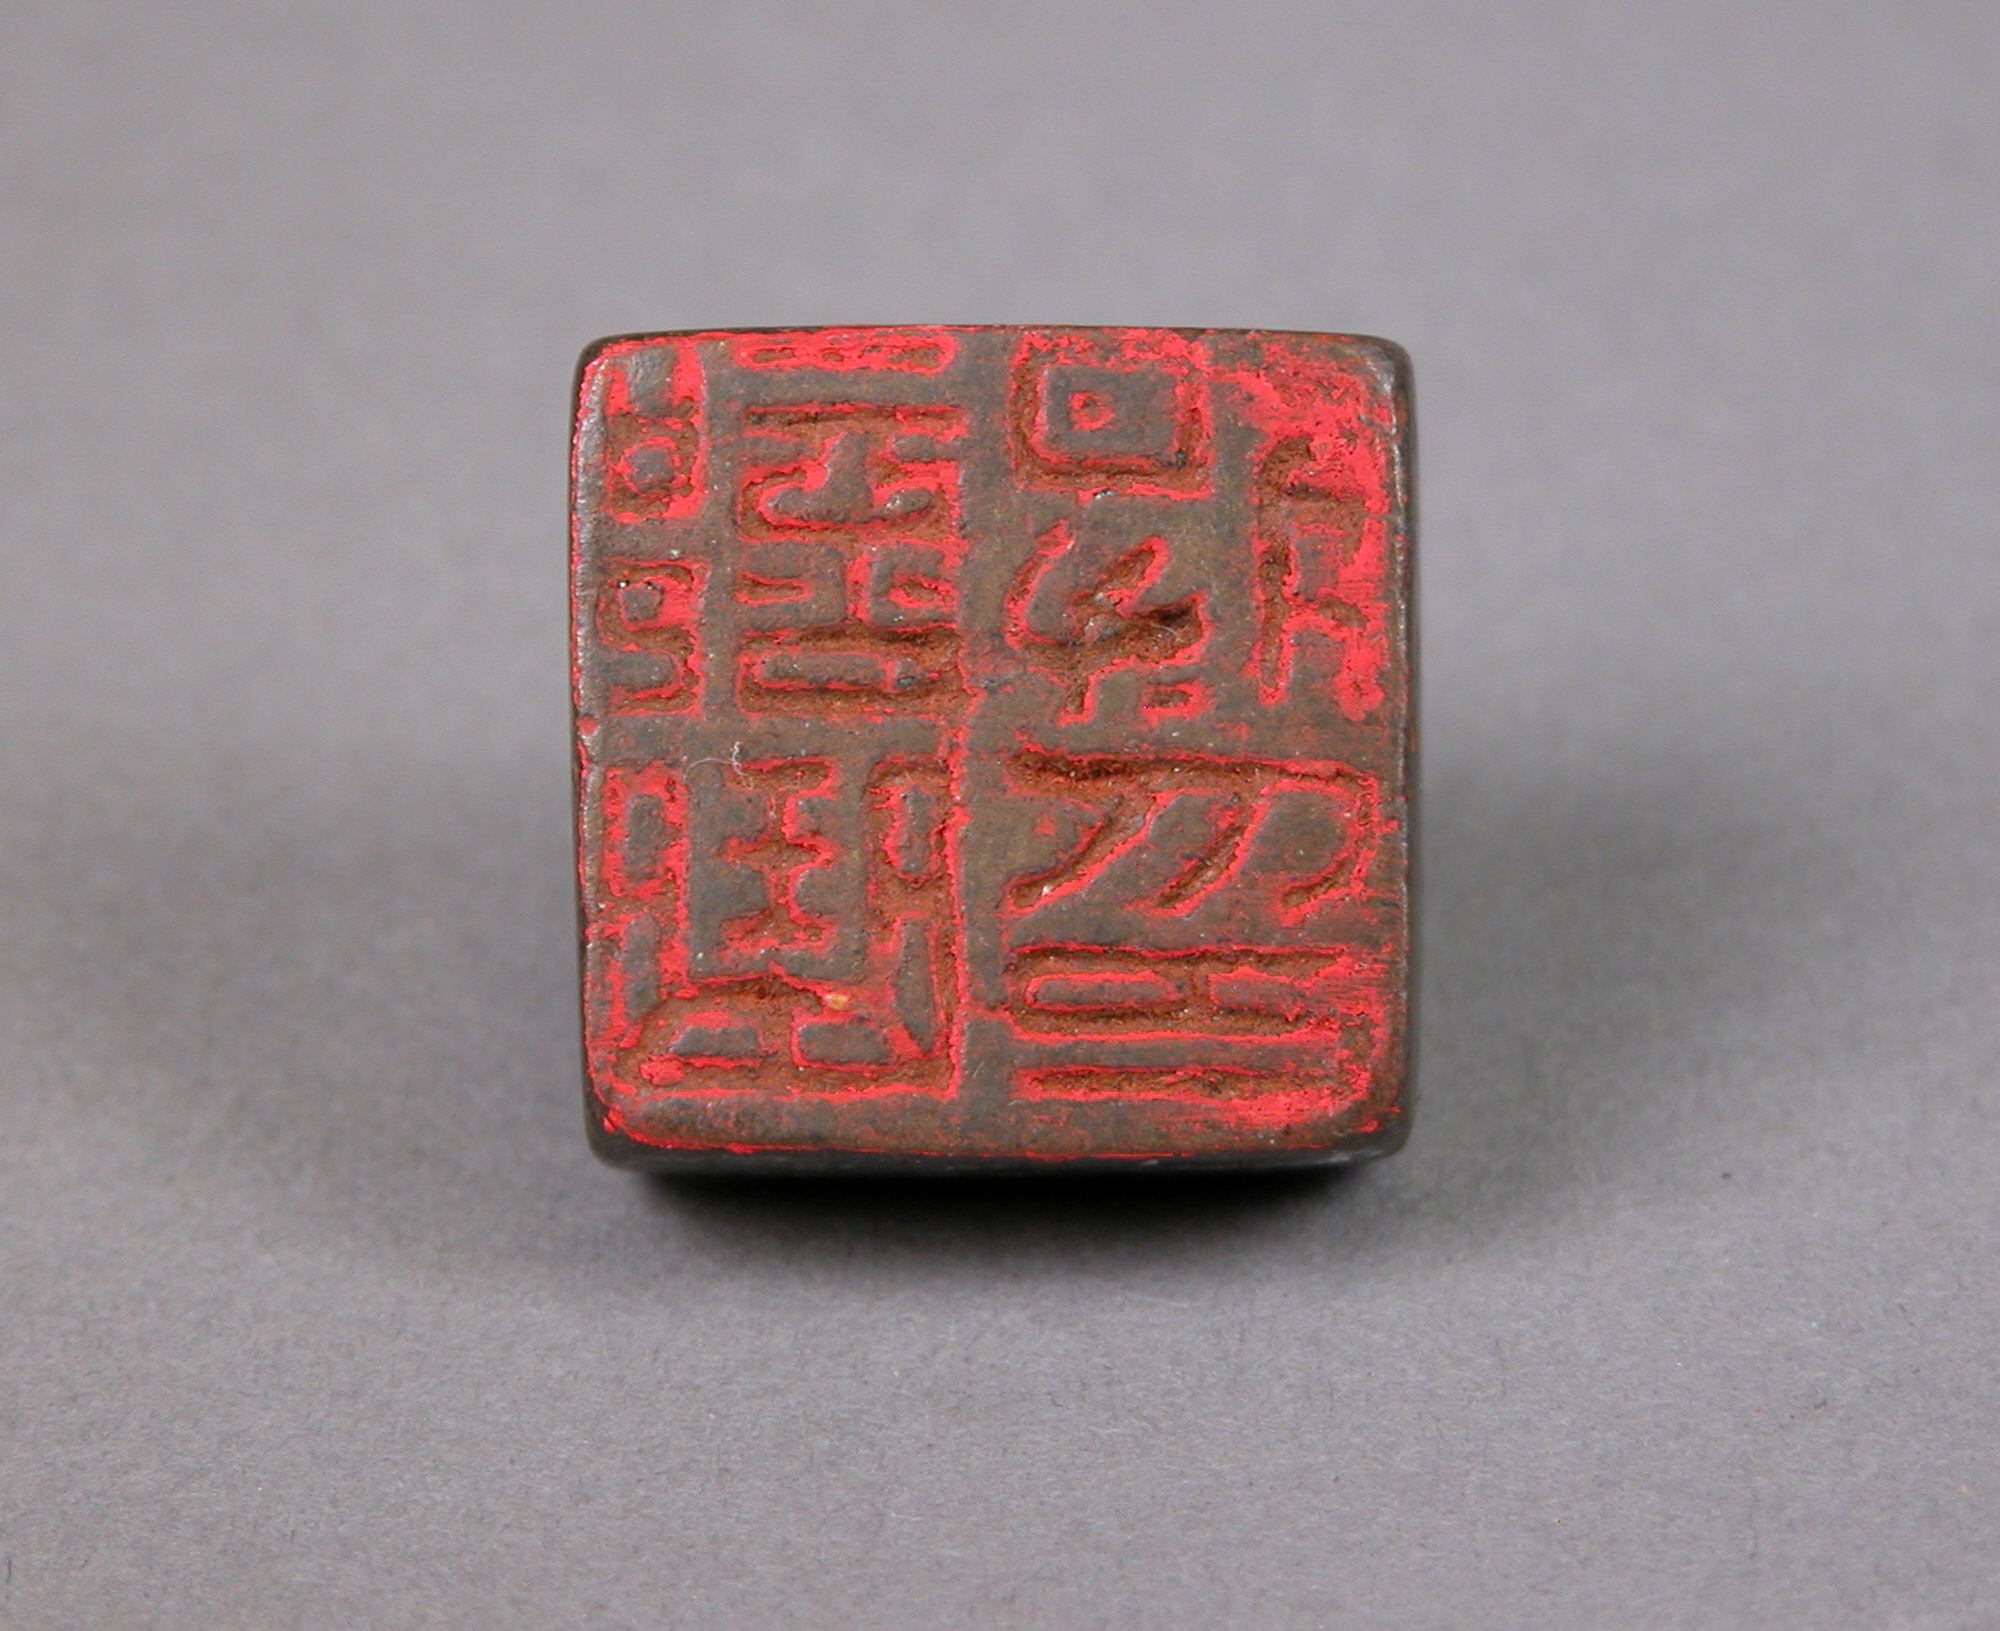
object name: seal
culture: chinese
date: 1300-1644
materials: bronze